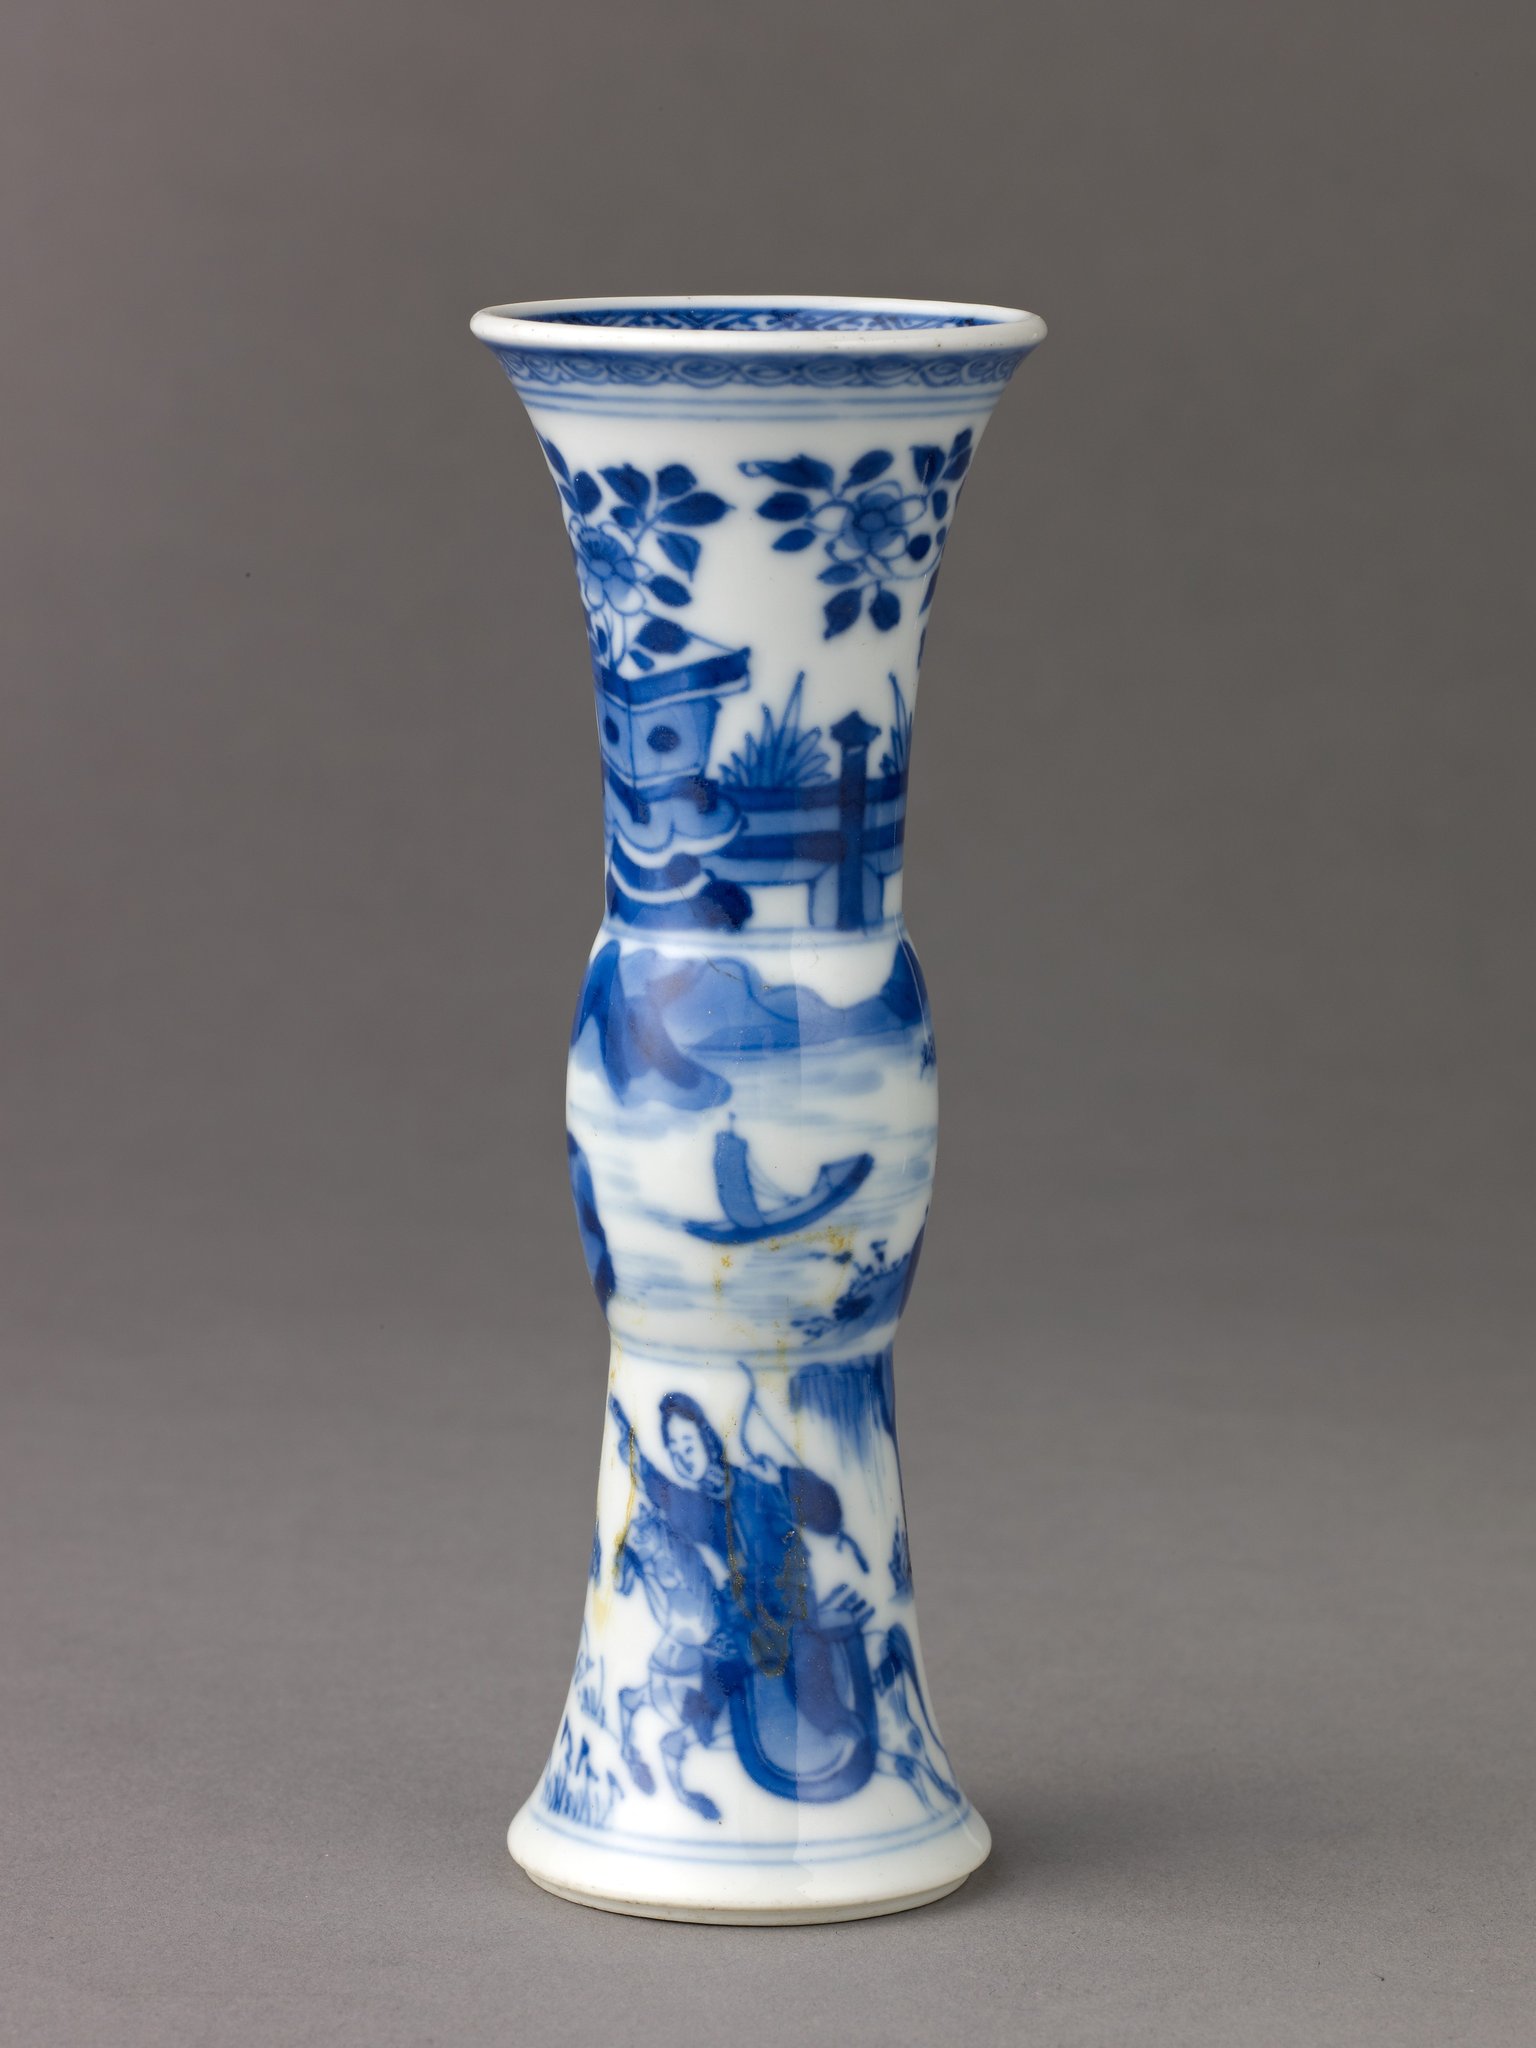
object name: vase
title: Small vase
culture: chinese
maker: chinese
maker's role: artist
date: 1662-1722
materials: porcelain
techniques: painting, underglaze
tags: horses